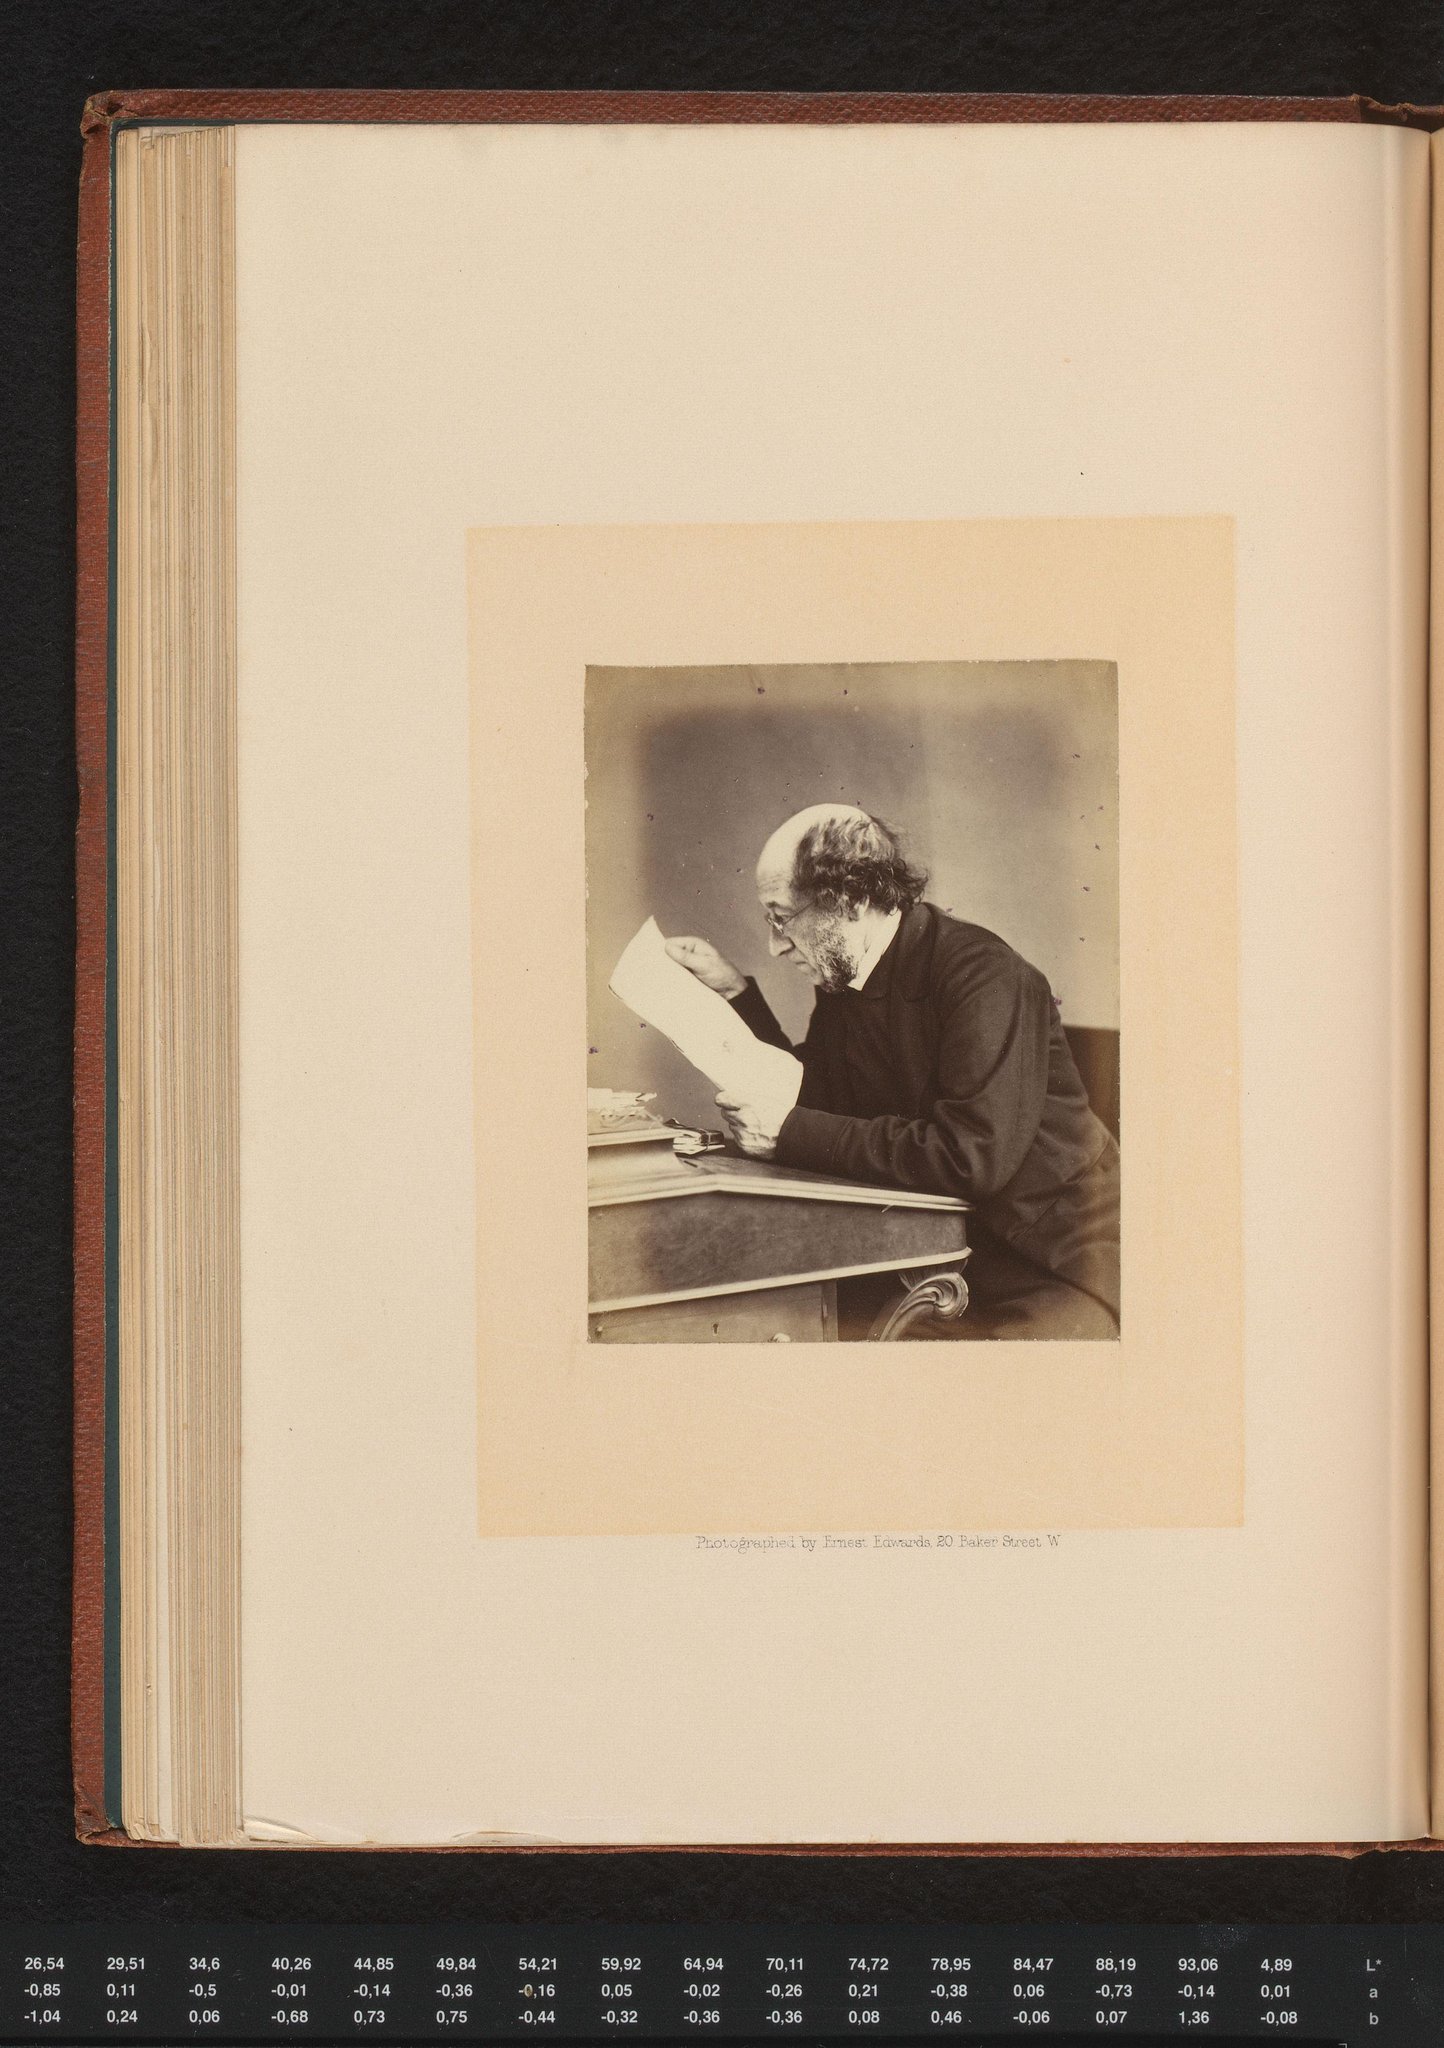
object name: page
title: Portret van de schrijver William John Thoms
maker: ernest edwards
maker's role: fotograaf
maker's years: 1837-1903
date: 1862-1867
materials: paper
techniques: albumen print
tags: portrait of a writer